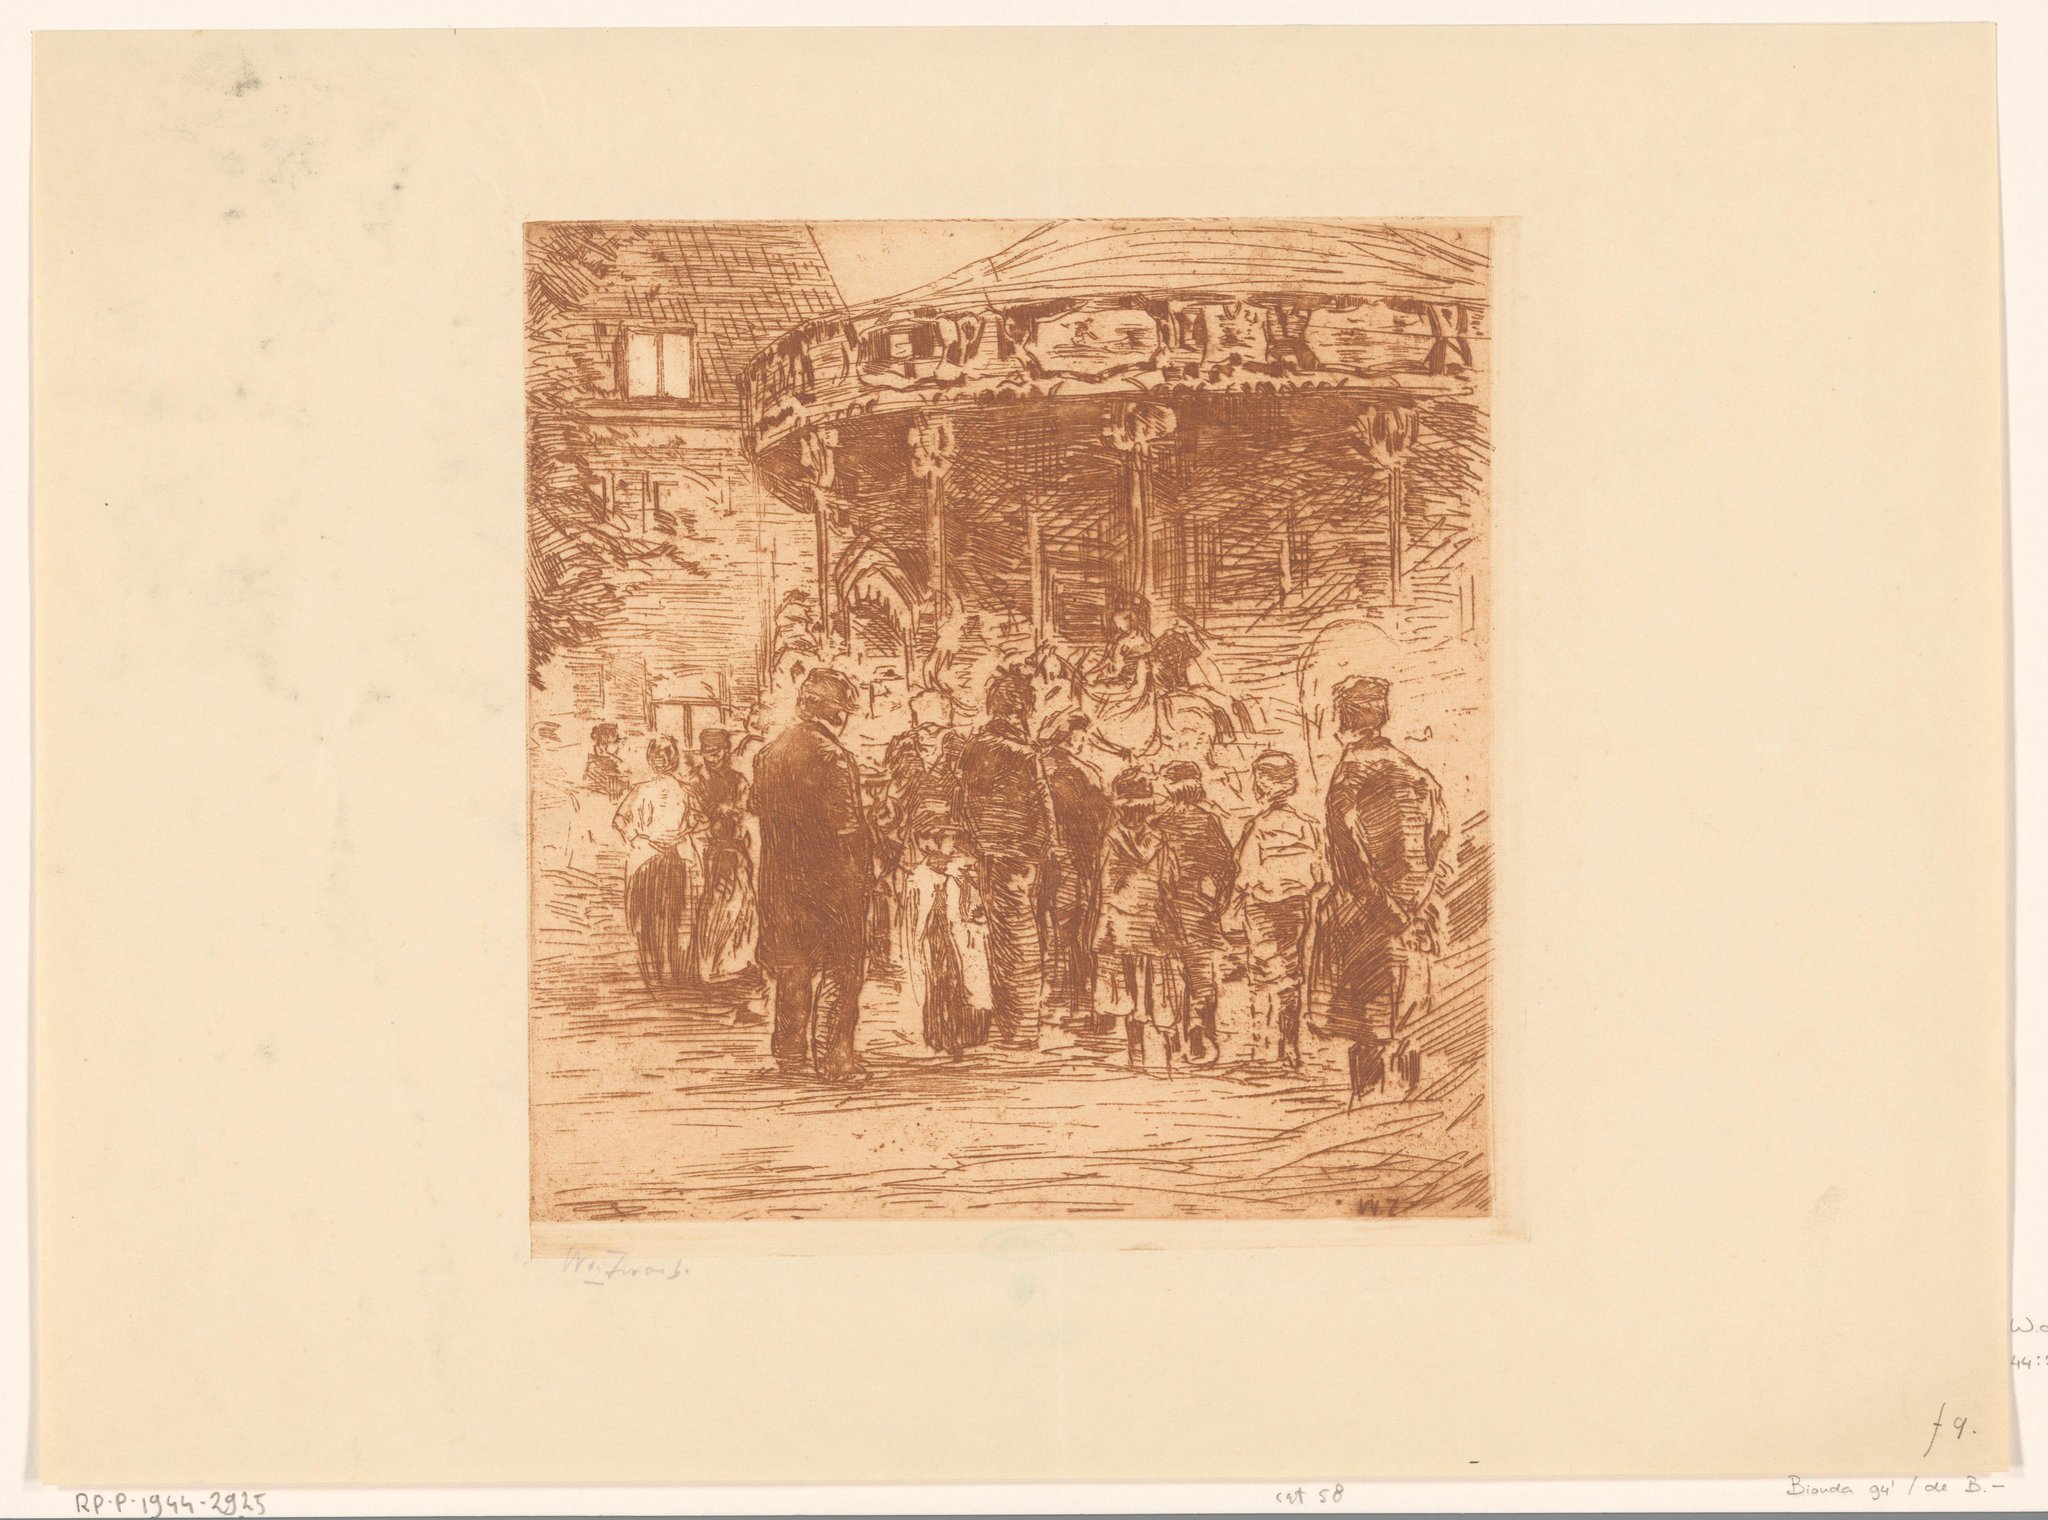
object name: print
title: Draaimolen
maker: willem de zwart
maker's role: draughtsman, painter, print maker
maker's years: 1862-1931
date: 1897-1898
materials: paper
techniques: etching, intaglio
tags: merry-go-round, roundabout; chair o'plane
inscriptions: collector's mark: Lugt 2228, collector's mark: Lugt 2760